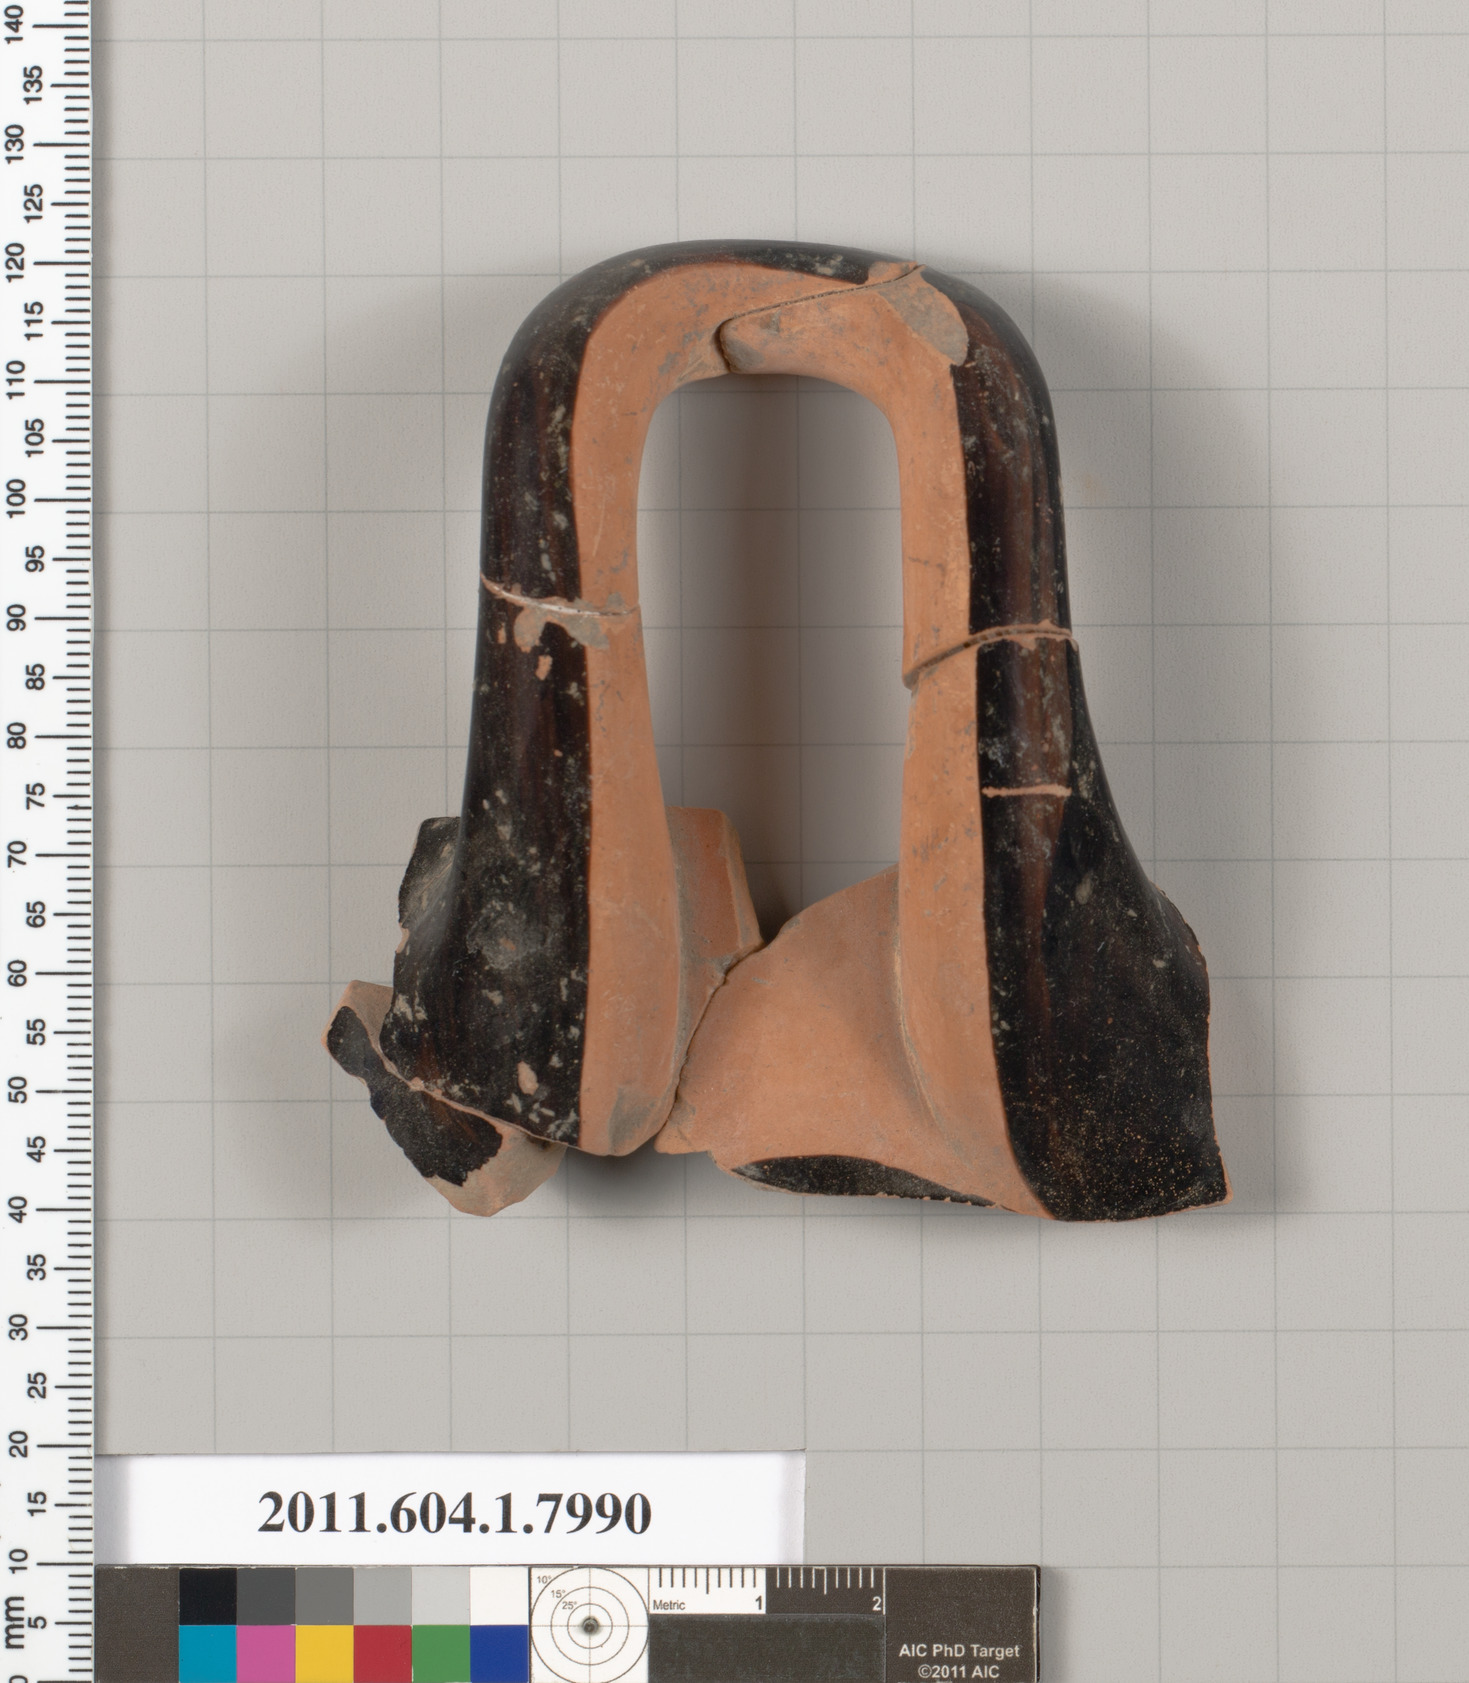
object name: kylix fragment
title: Terracotta fragment of a kylix (drinking cup)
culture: greek, attic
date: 460-450 BCE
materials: terracotta